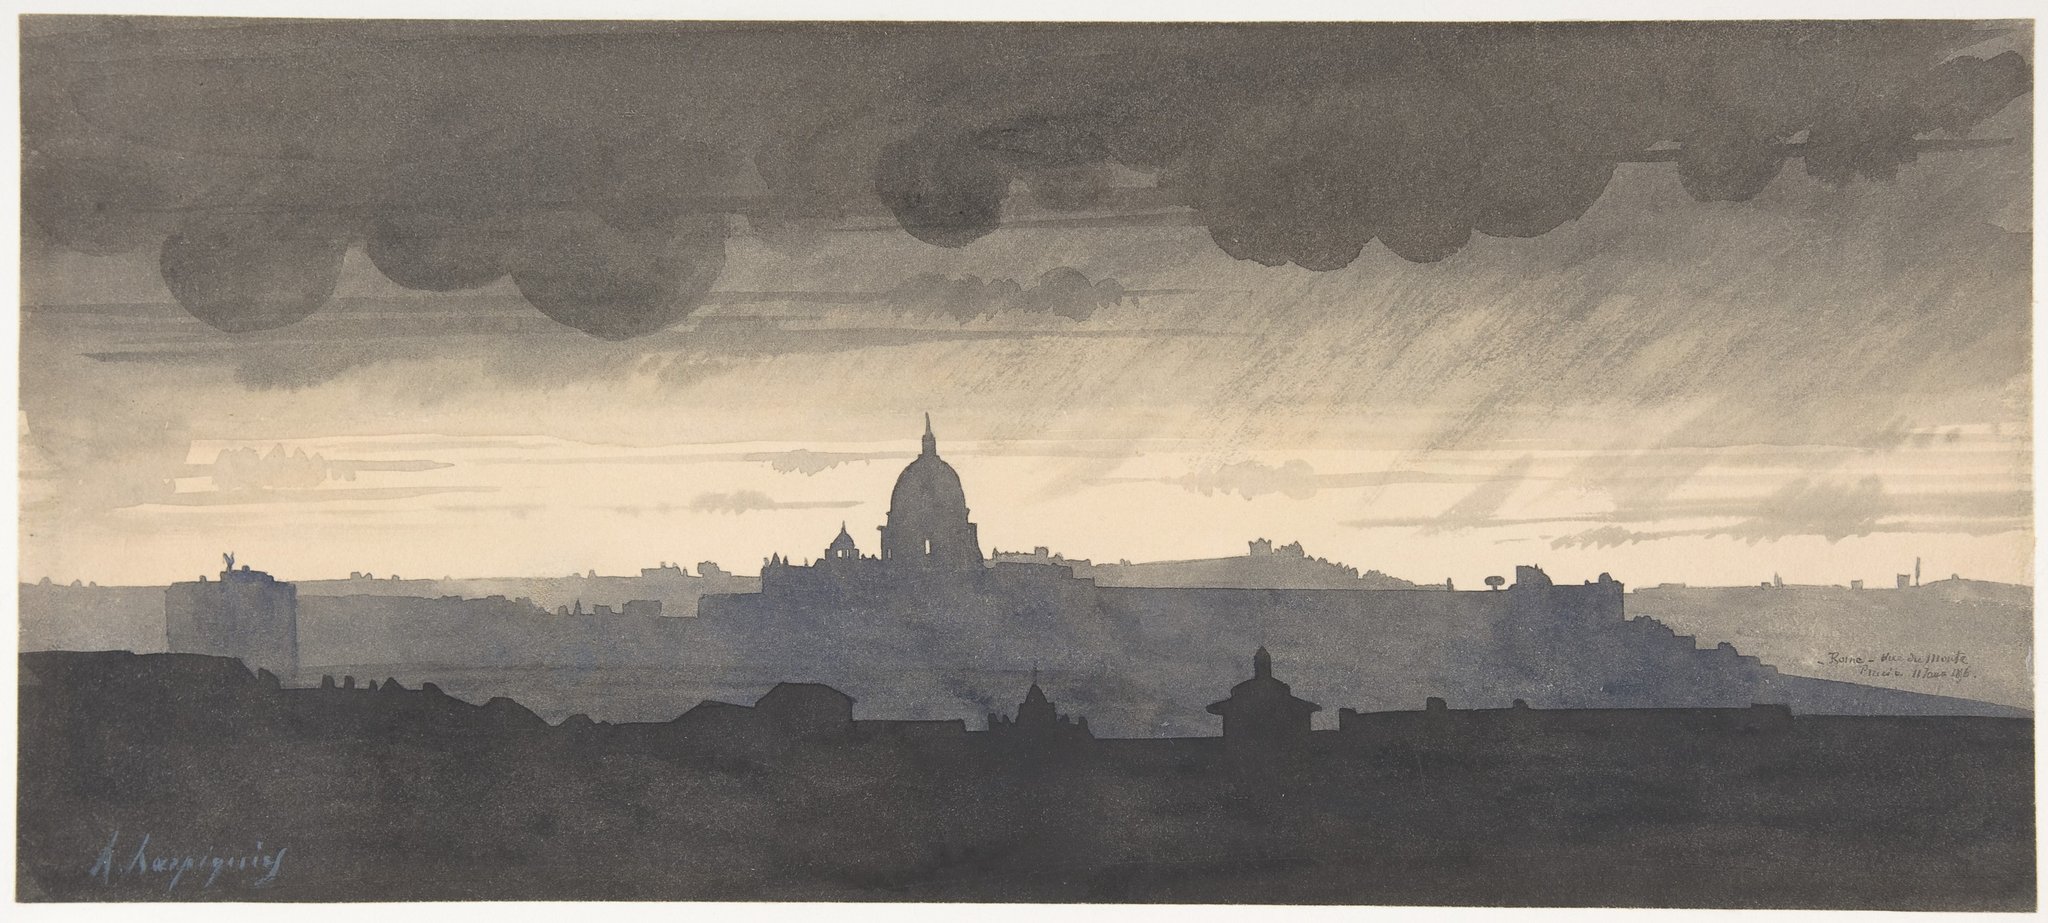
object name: drawing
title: Saint Peter's Seen From the Pincio, Rome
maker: henri-joseph harpignies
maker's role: artist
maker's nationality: french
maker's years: 1819-1916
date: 1856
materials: ink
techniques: brush, pen, wash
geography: france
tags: cities,clouds,rome